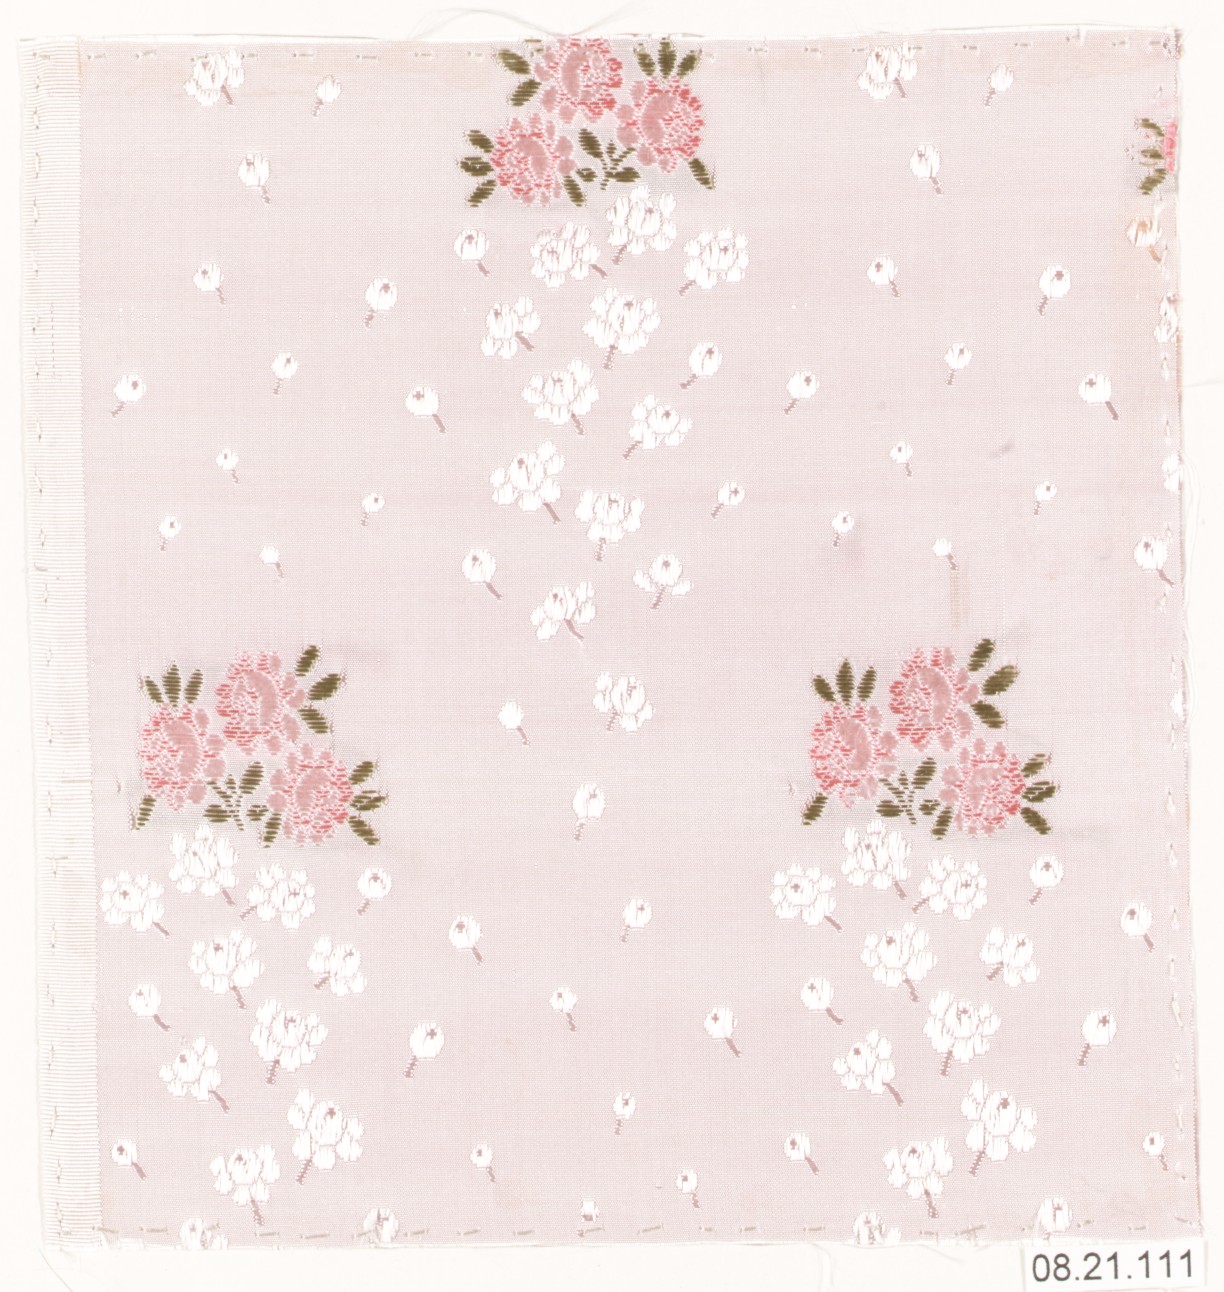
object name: textile sample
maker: Anonymous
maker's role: designer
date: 1900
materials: silk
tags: flowers